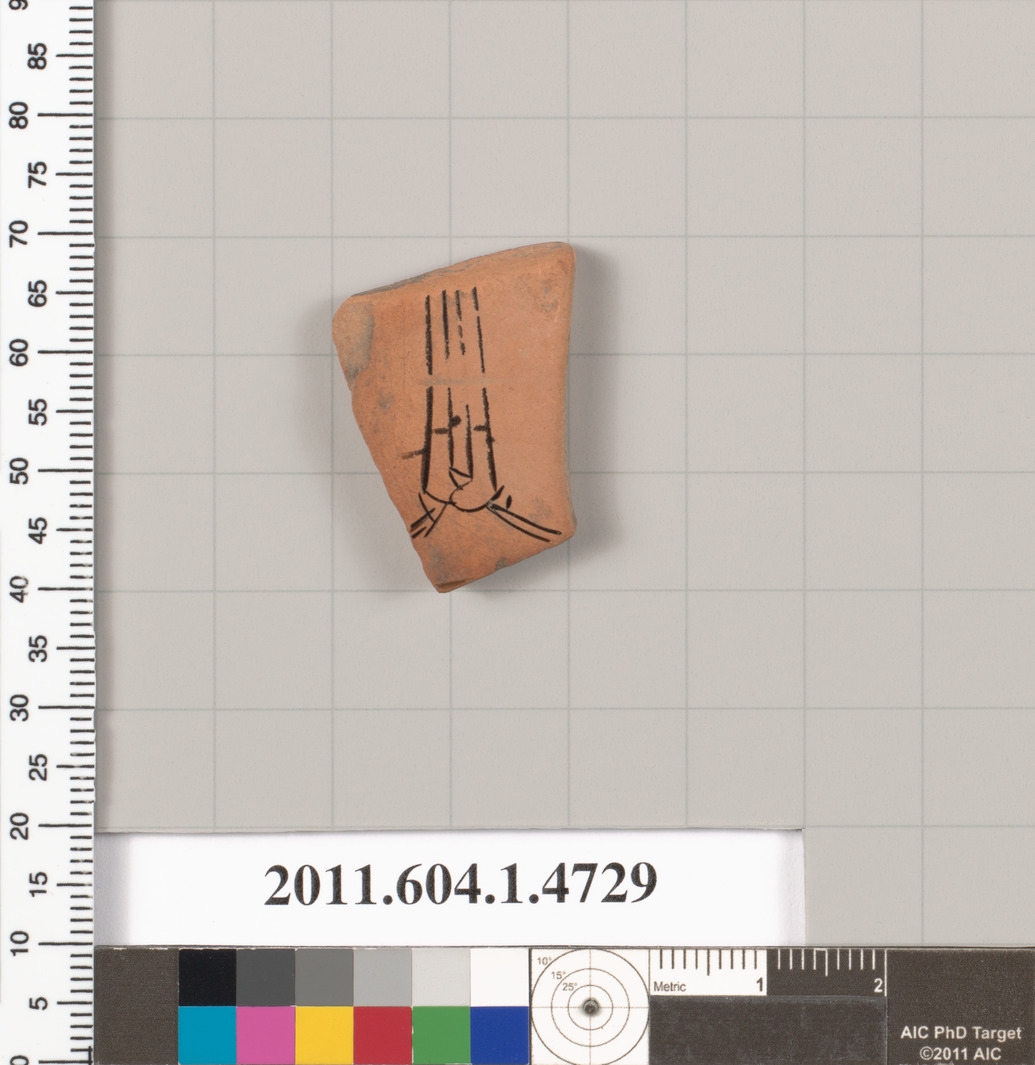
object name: kylix fragment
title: Terracotta fragment of a kylix (drinking cup)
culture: greek, attic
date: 490-480 BCE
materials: terracotta